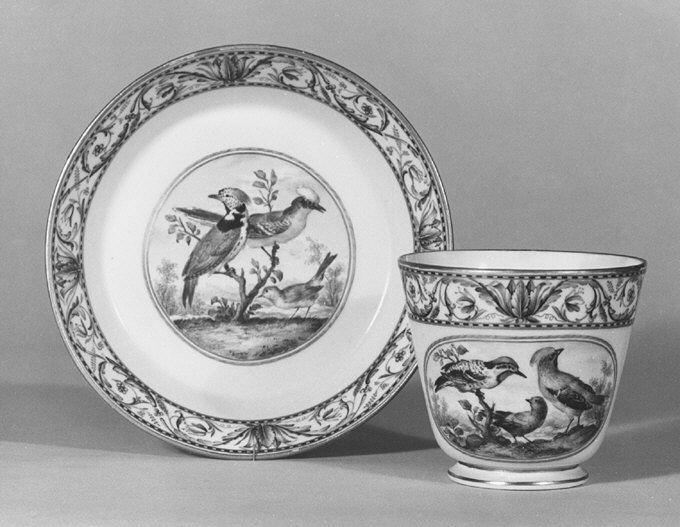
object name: coffee cup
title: Coffee cup (part of a service)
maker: meissen manufactory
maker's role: manufactory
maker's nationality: german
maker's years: 1710-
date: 1780-1785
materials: hard paste porcelain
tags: birds